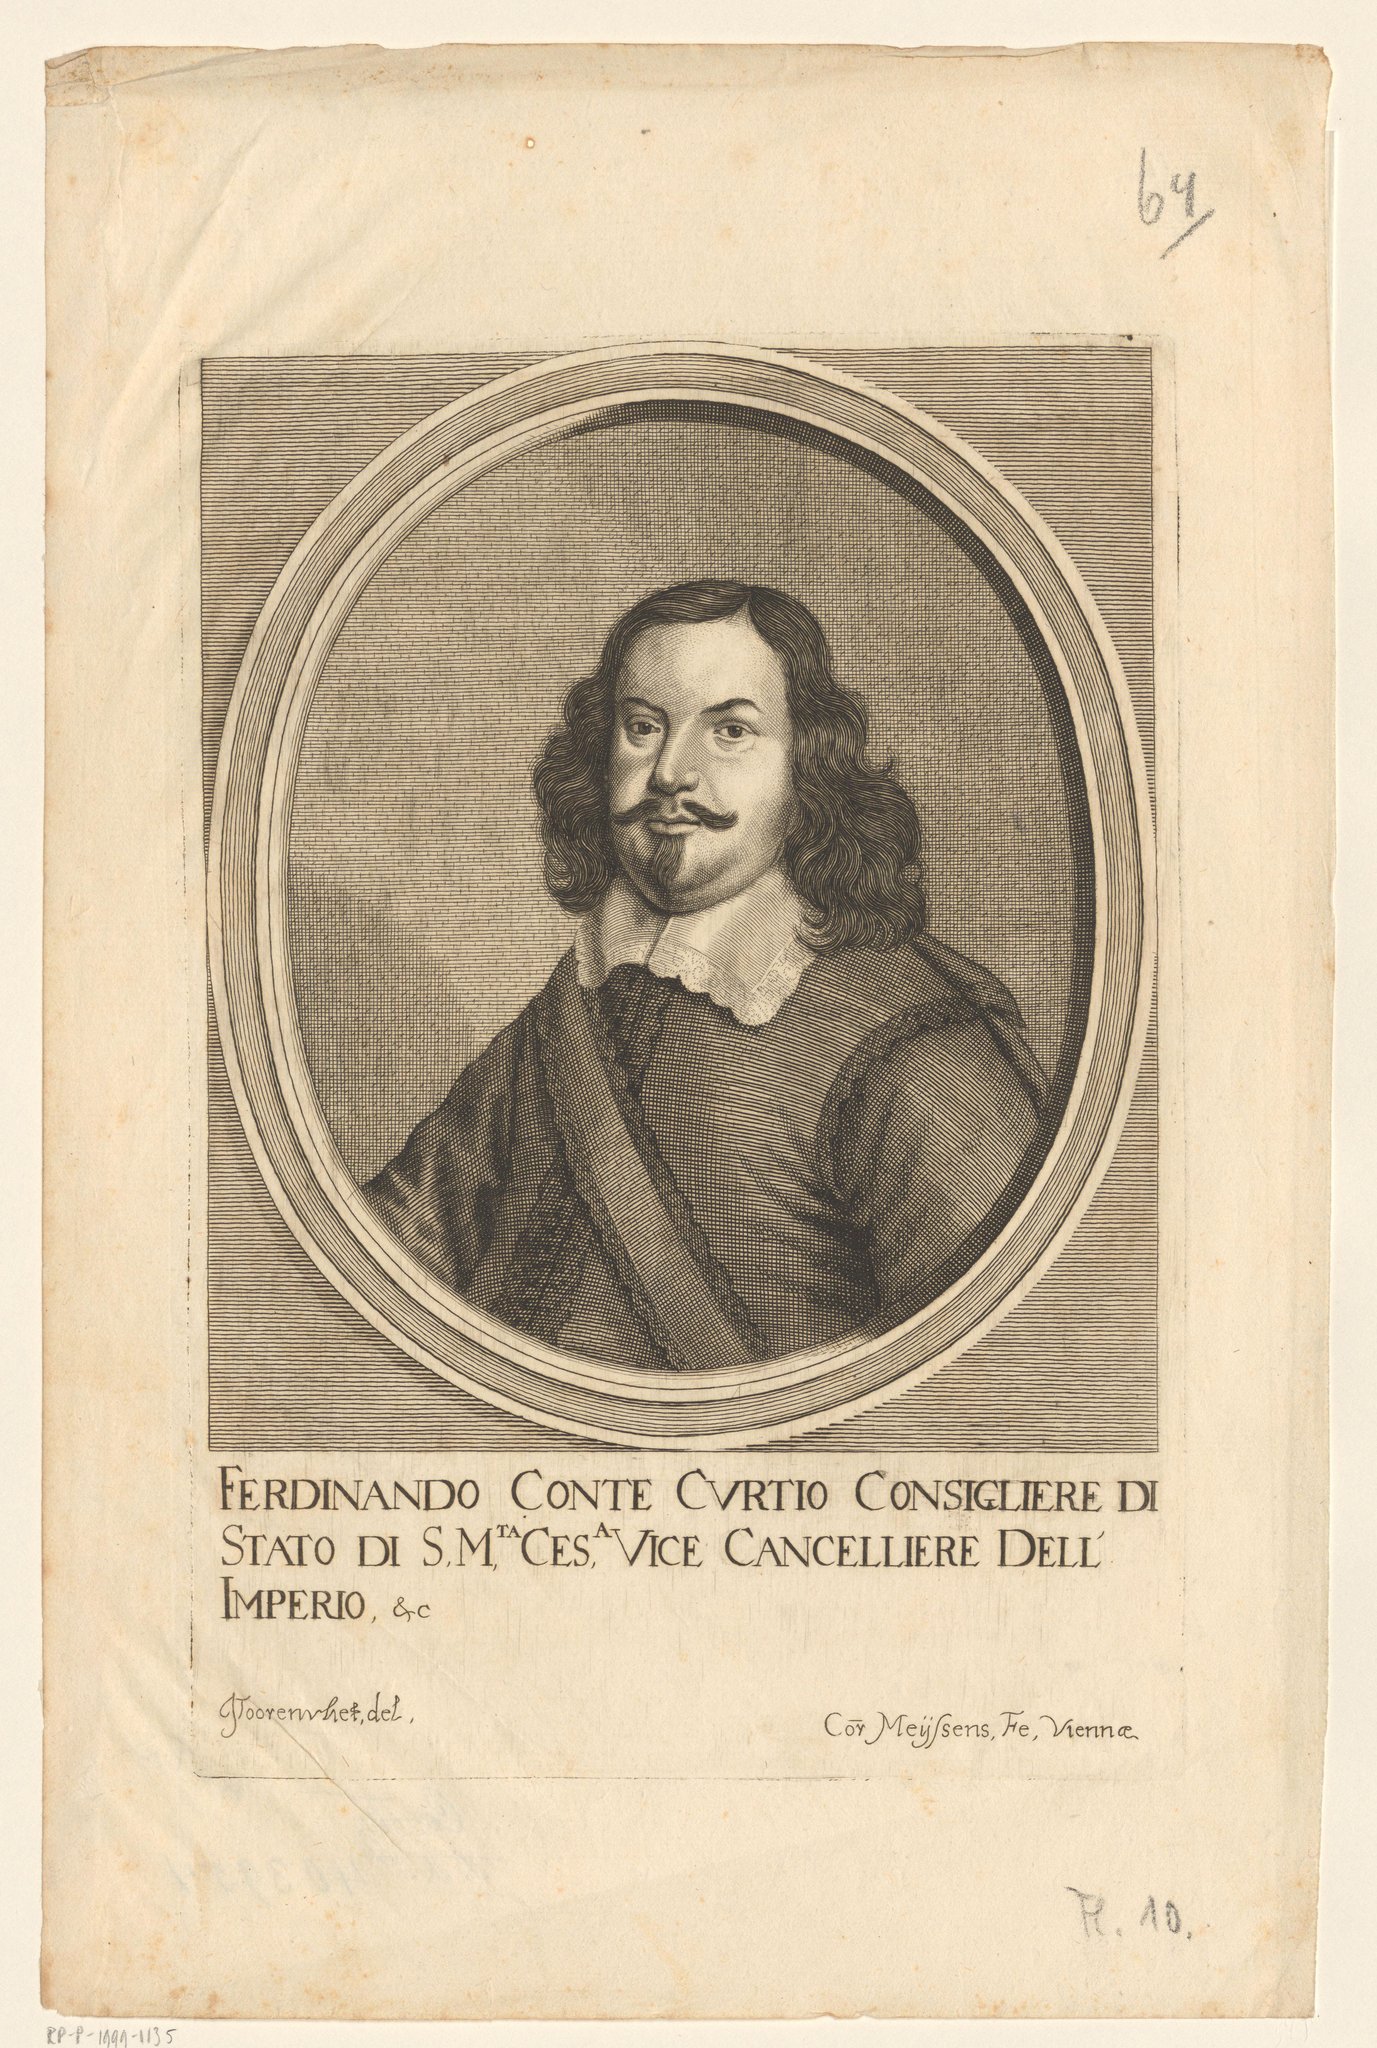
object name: print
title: Portret van Ferdinand Sigismund Kurtz von Senftenau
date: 1670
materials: paper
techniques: engraving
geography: vienna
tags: historical persons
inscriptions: collector's mark: Lugt 2228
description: Prent mogelijk uit: Priorato, Galeazzo Gualdo. Historia di Leopoldo Cesare. Wenen: Giovanni Battista Hacque, 1670.